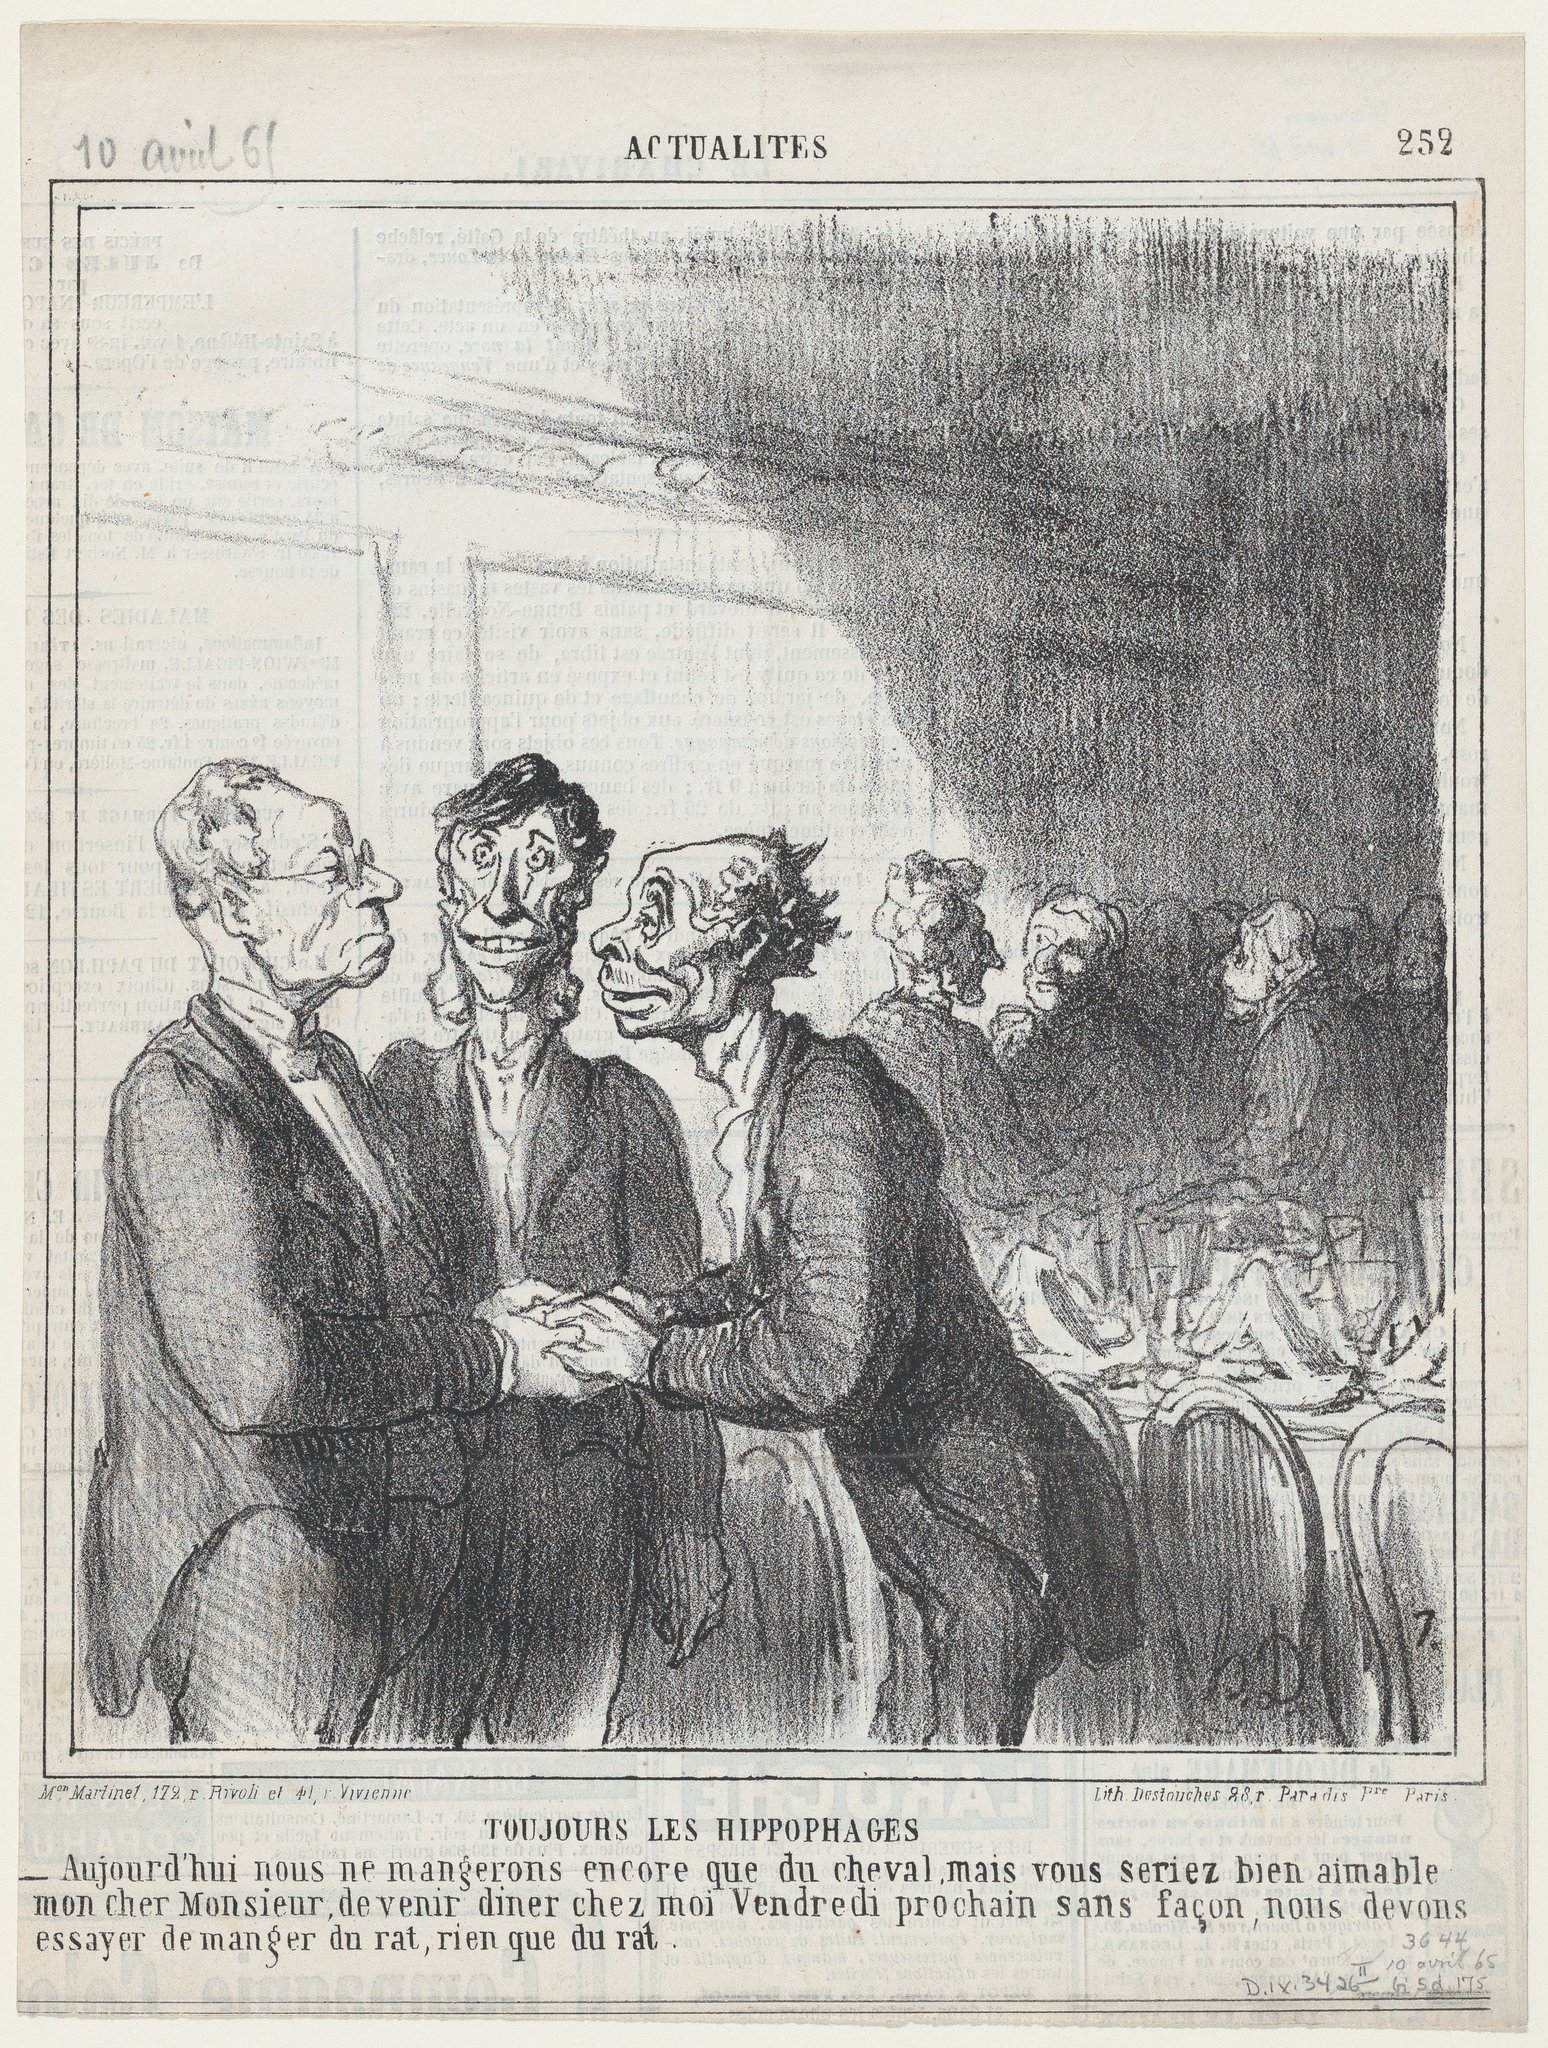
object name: print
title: Among two bailiffs, from "News of the day"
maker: honoré daumier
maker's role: artist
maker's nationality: french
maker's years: 1808-1879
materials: paper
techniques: lithograph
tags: satire,men